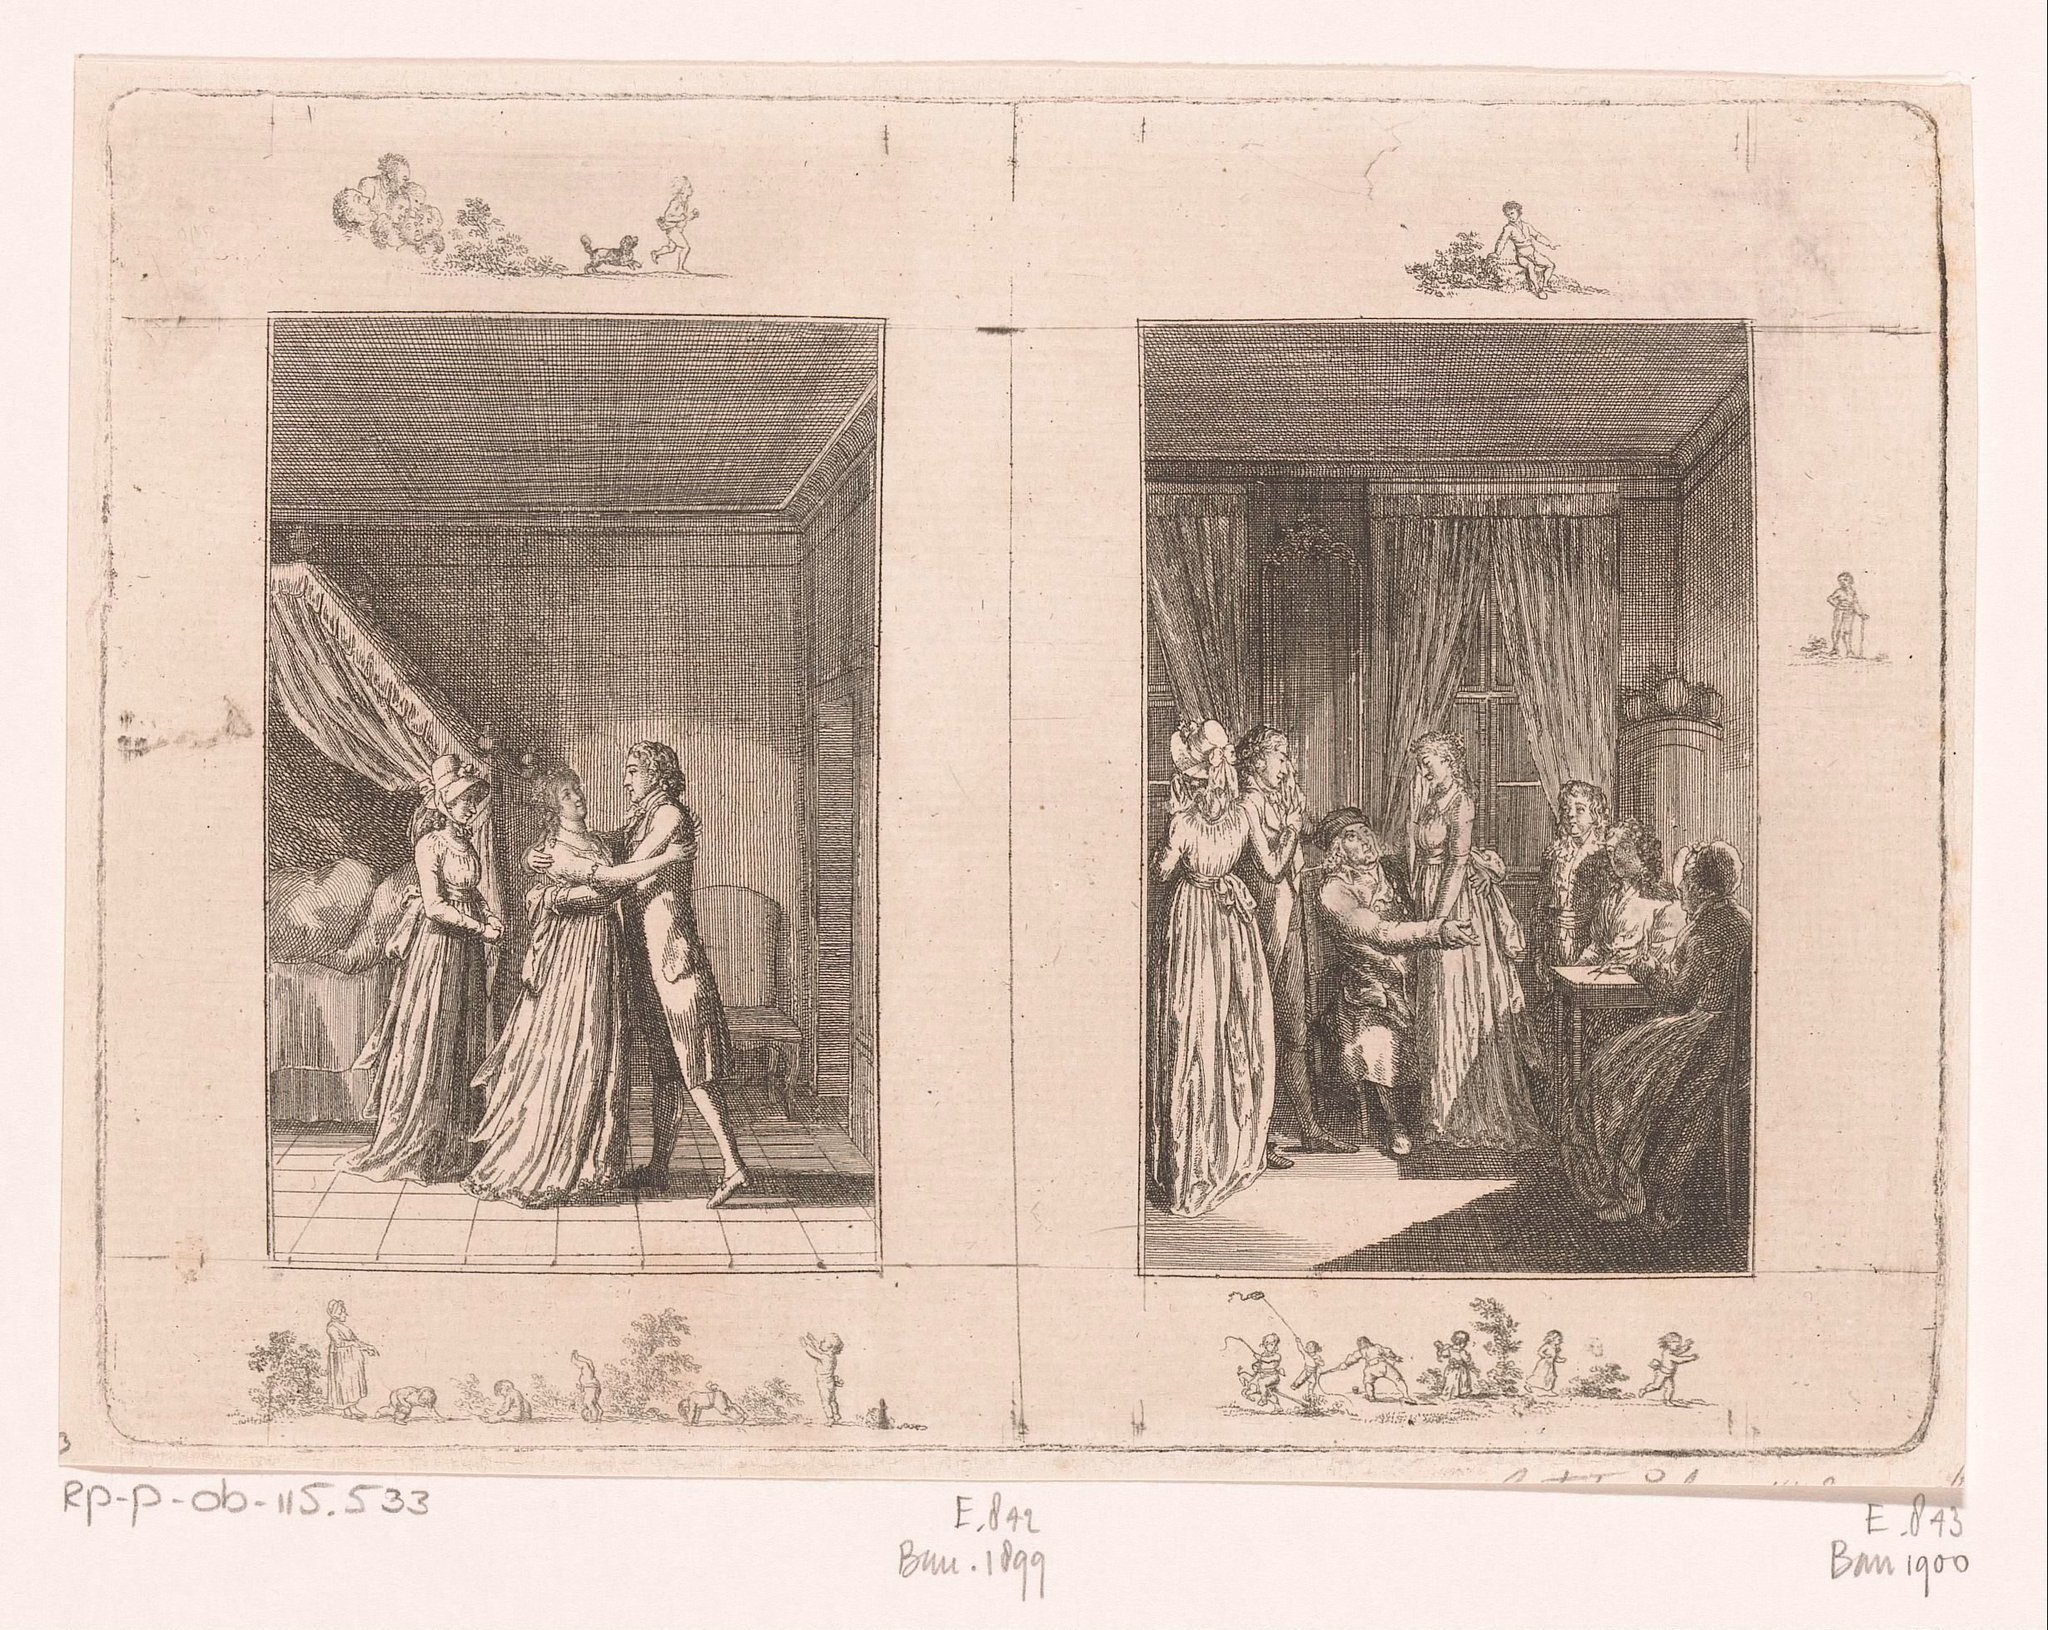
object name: print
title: Twee voorstellingen uit de verhalen van Wilhelm Gottlieb Becker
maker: daniel nikolaus chodowiecki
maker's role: draughtsman, print maker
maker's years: 1726-1801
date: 1797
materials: paper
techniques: etching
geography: berlin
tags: consolation, literature, (lovers) embracing each other, 'symplegma', weeping, bedroom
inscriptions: collector's mark: Lugt 2228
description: Latere staat gebruikt voor: Becker, Wilhelm Gottlieb. Almanach und Taschenbuch zum geselligen Vergnügen von W. G. Becker für 1798. Leipzig: Voss und Comp., [1797].